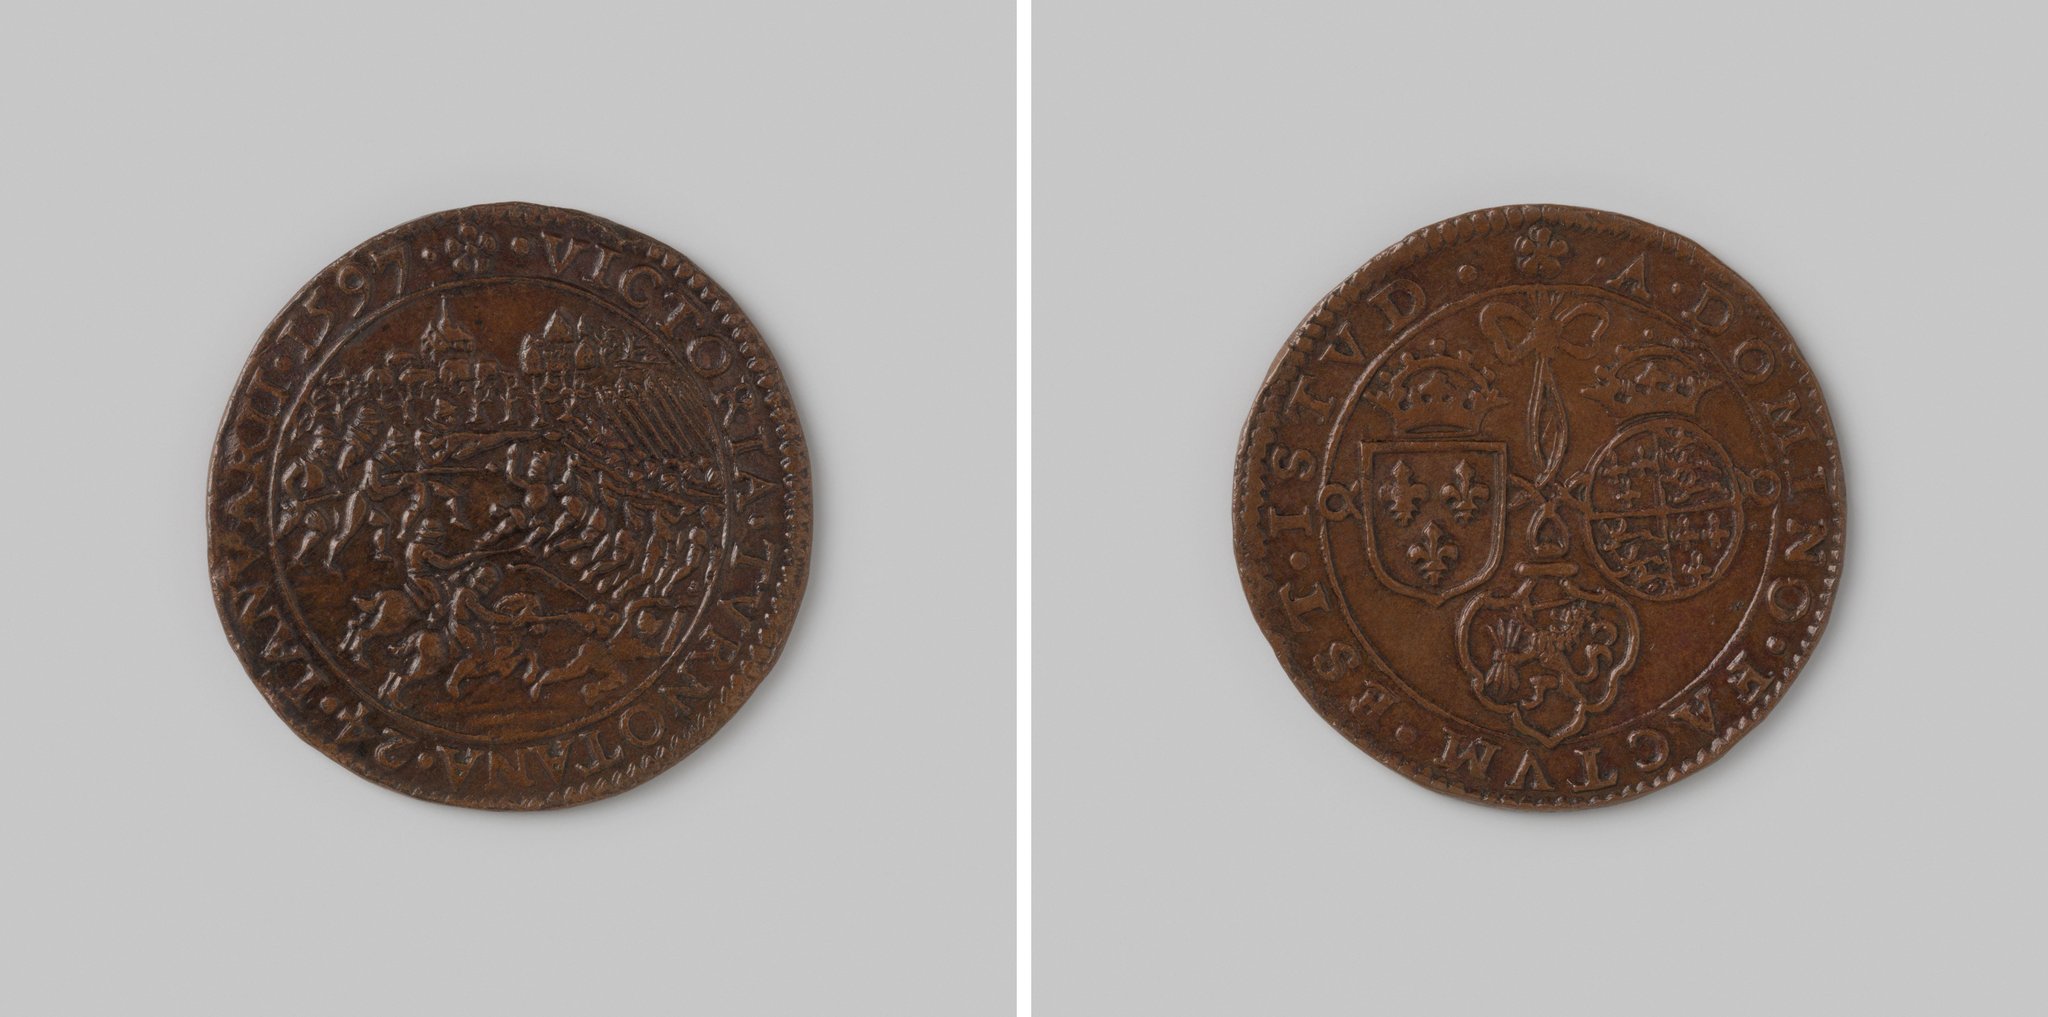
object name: jeton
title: Rekenpenning uit Dordrecht op de overwinning in de Slag bij bij Turnhout 1597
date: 1597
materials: copper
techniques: striking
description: Koperen penning, op de voorzijde het verdrijven van het vijandelijke leger, met omschrift, op de keerzijde aan één lint de wapenschilden van Frankrijk, Groot Brittannië en Nederland, met omschrift.